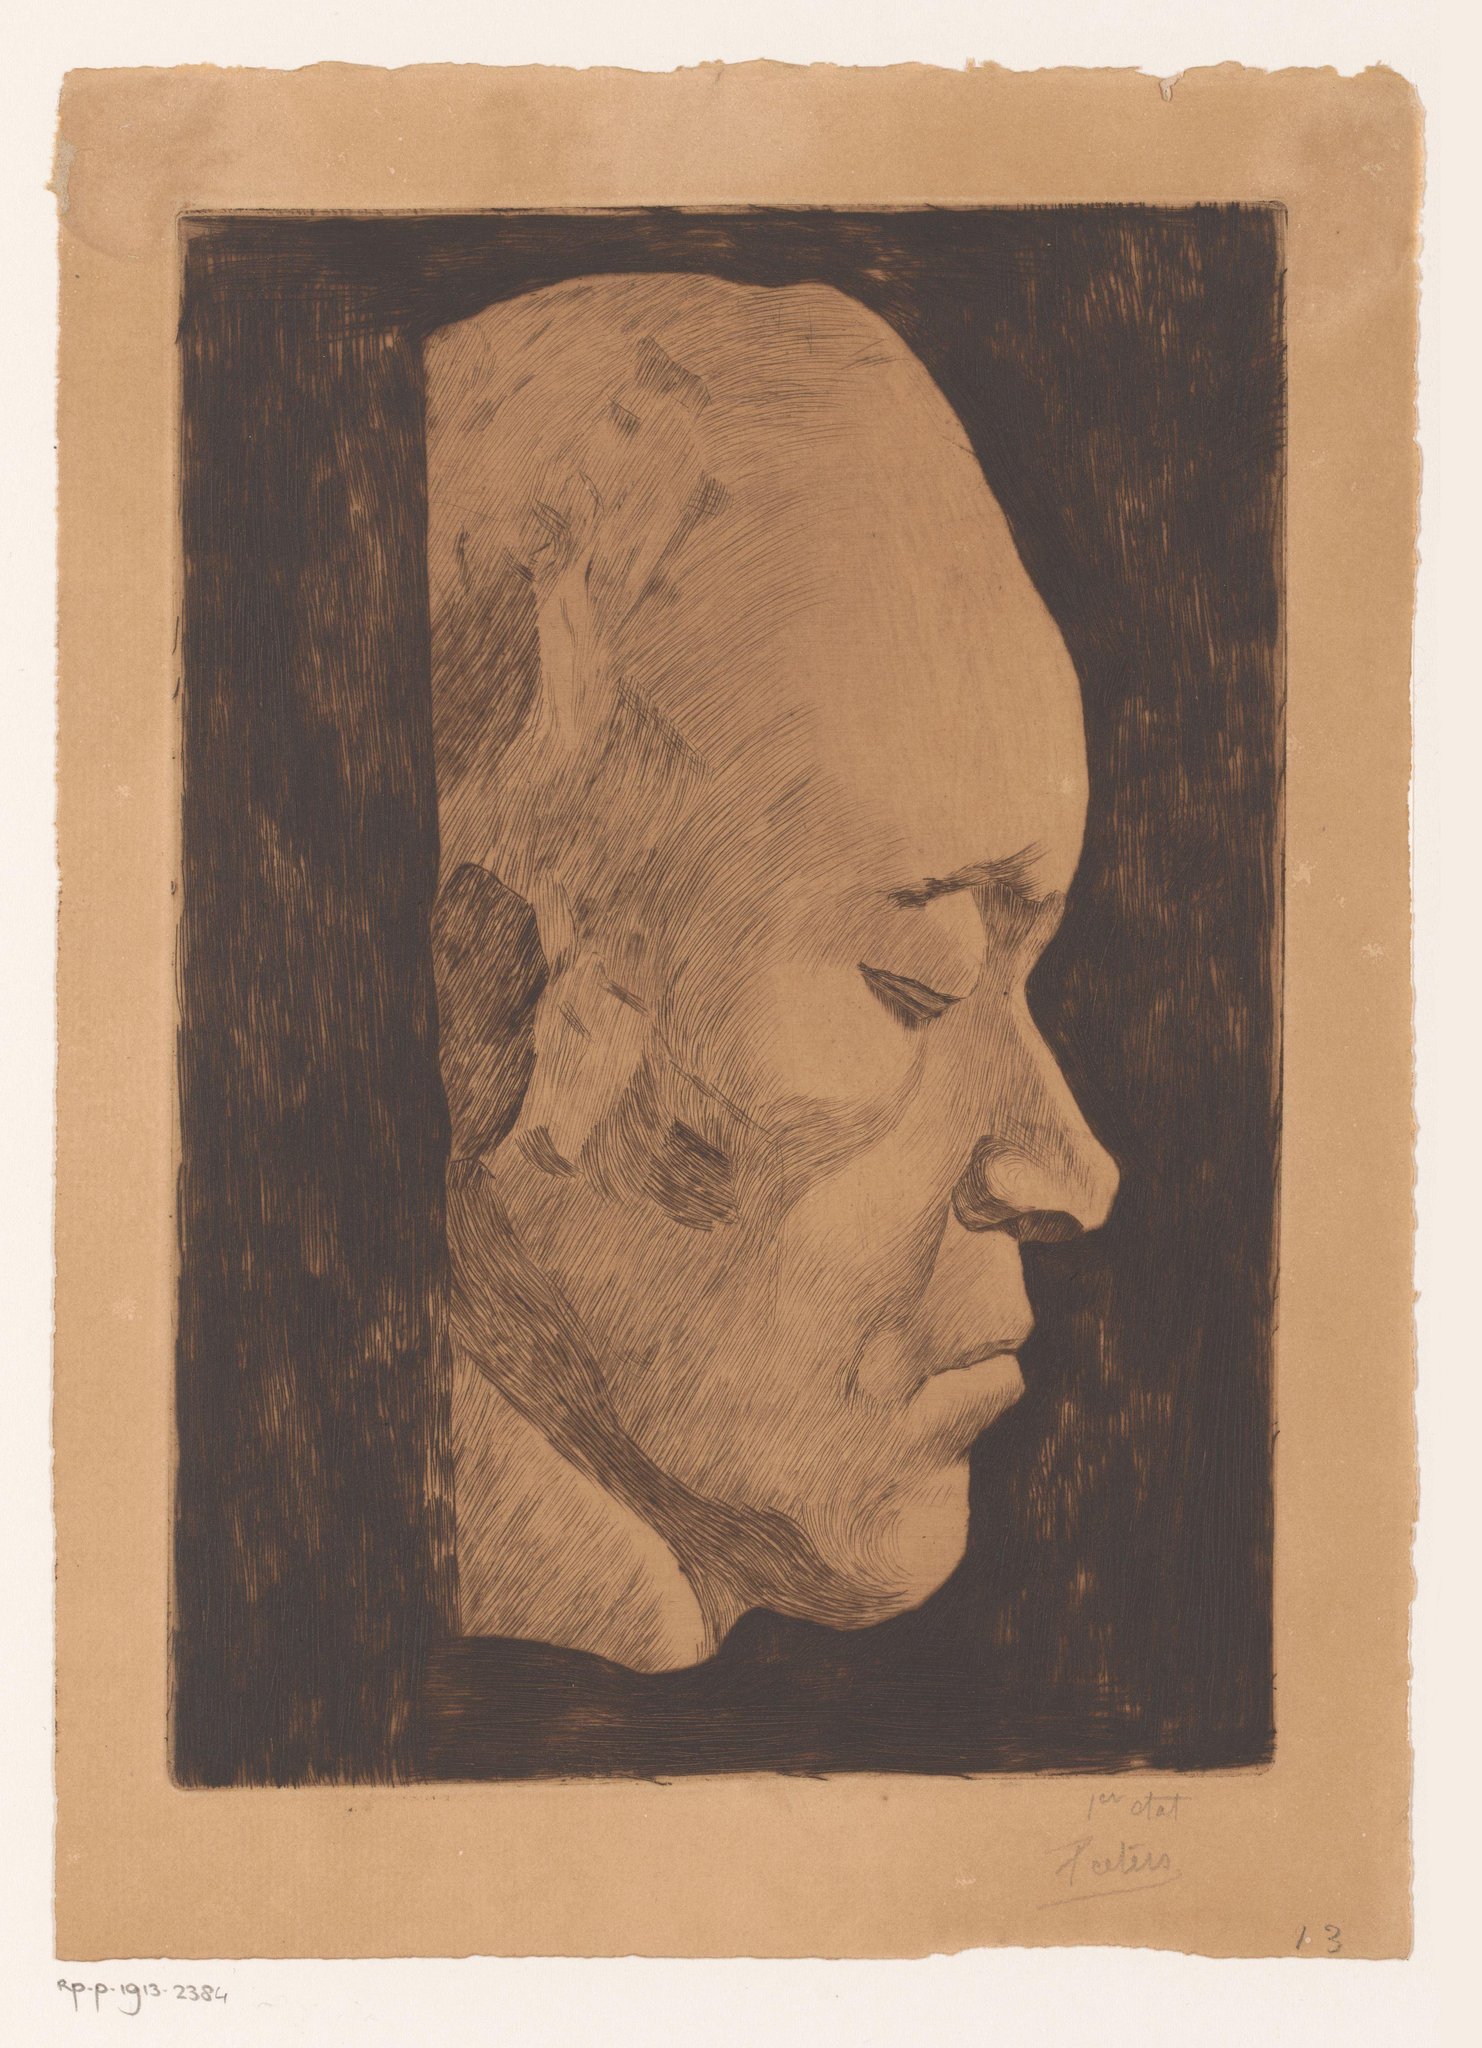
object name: print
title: Masker van Beethoven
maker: pierre peeters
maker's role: print maker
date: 1875-1913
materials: paper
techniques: drypoint, etching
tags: vienna, face - aa - mask (mould taken from face)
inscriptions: annotation: ‘1er etat’, collector's mark: Lugt 2228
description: Hoewel dit masker vaak foutief wordt aangeduid als doodsmasker, werd dit tijdens het leven van Beethoven door Franz Klein gemaakt. Er bestaat ook een doodsmasker, enkele uren na Beethovens overlijden gemaakt door Josef Danhauser. Geboorte- en sterfdatum van de prentmaker zijn onbekend. Daarom is voor de bepaling van de rechten van dit object gebruik gemaakt van de verwervingsdatum Rijksmuseum Amsterdam.